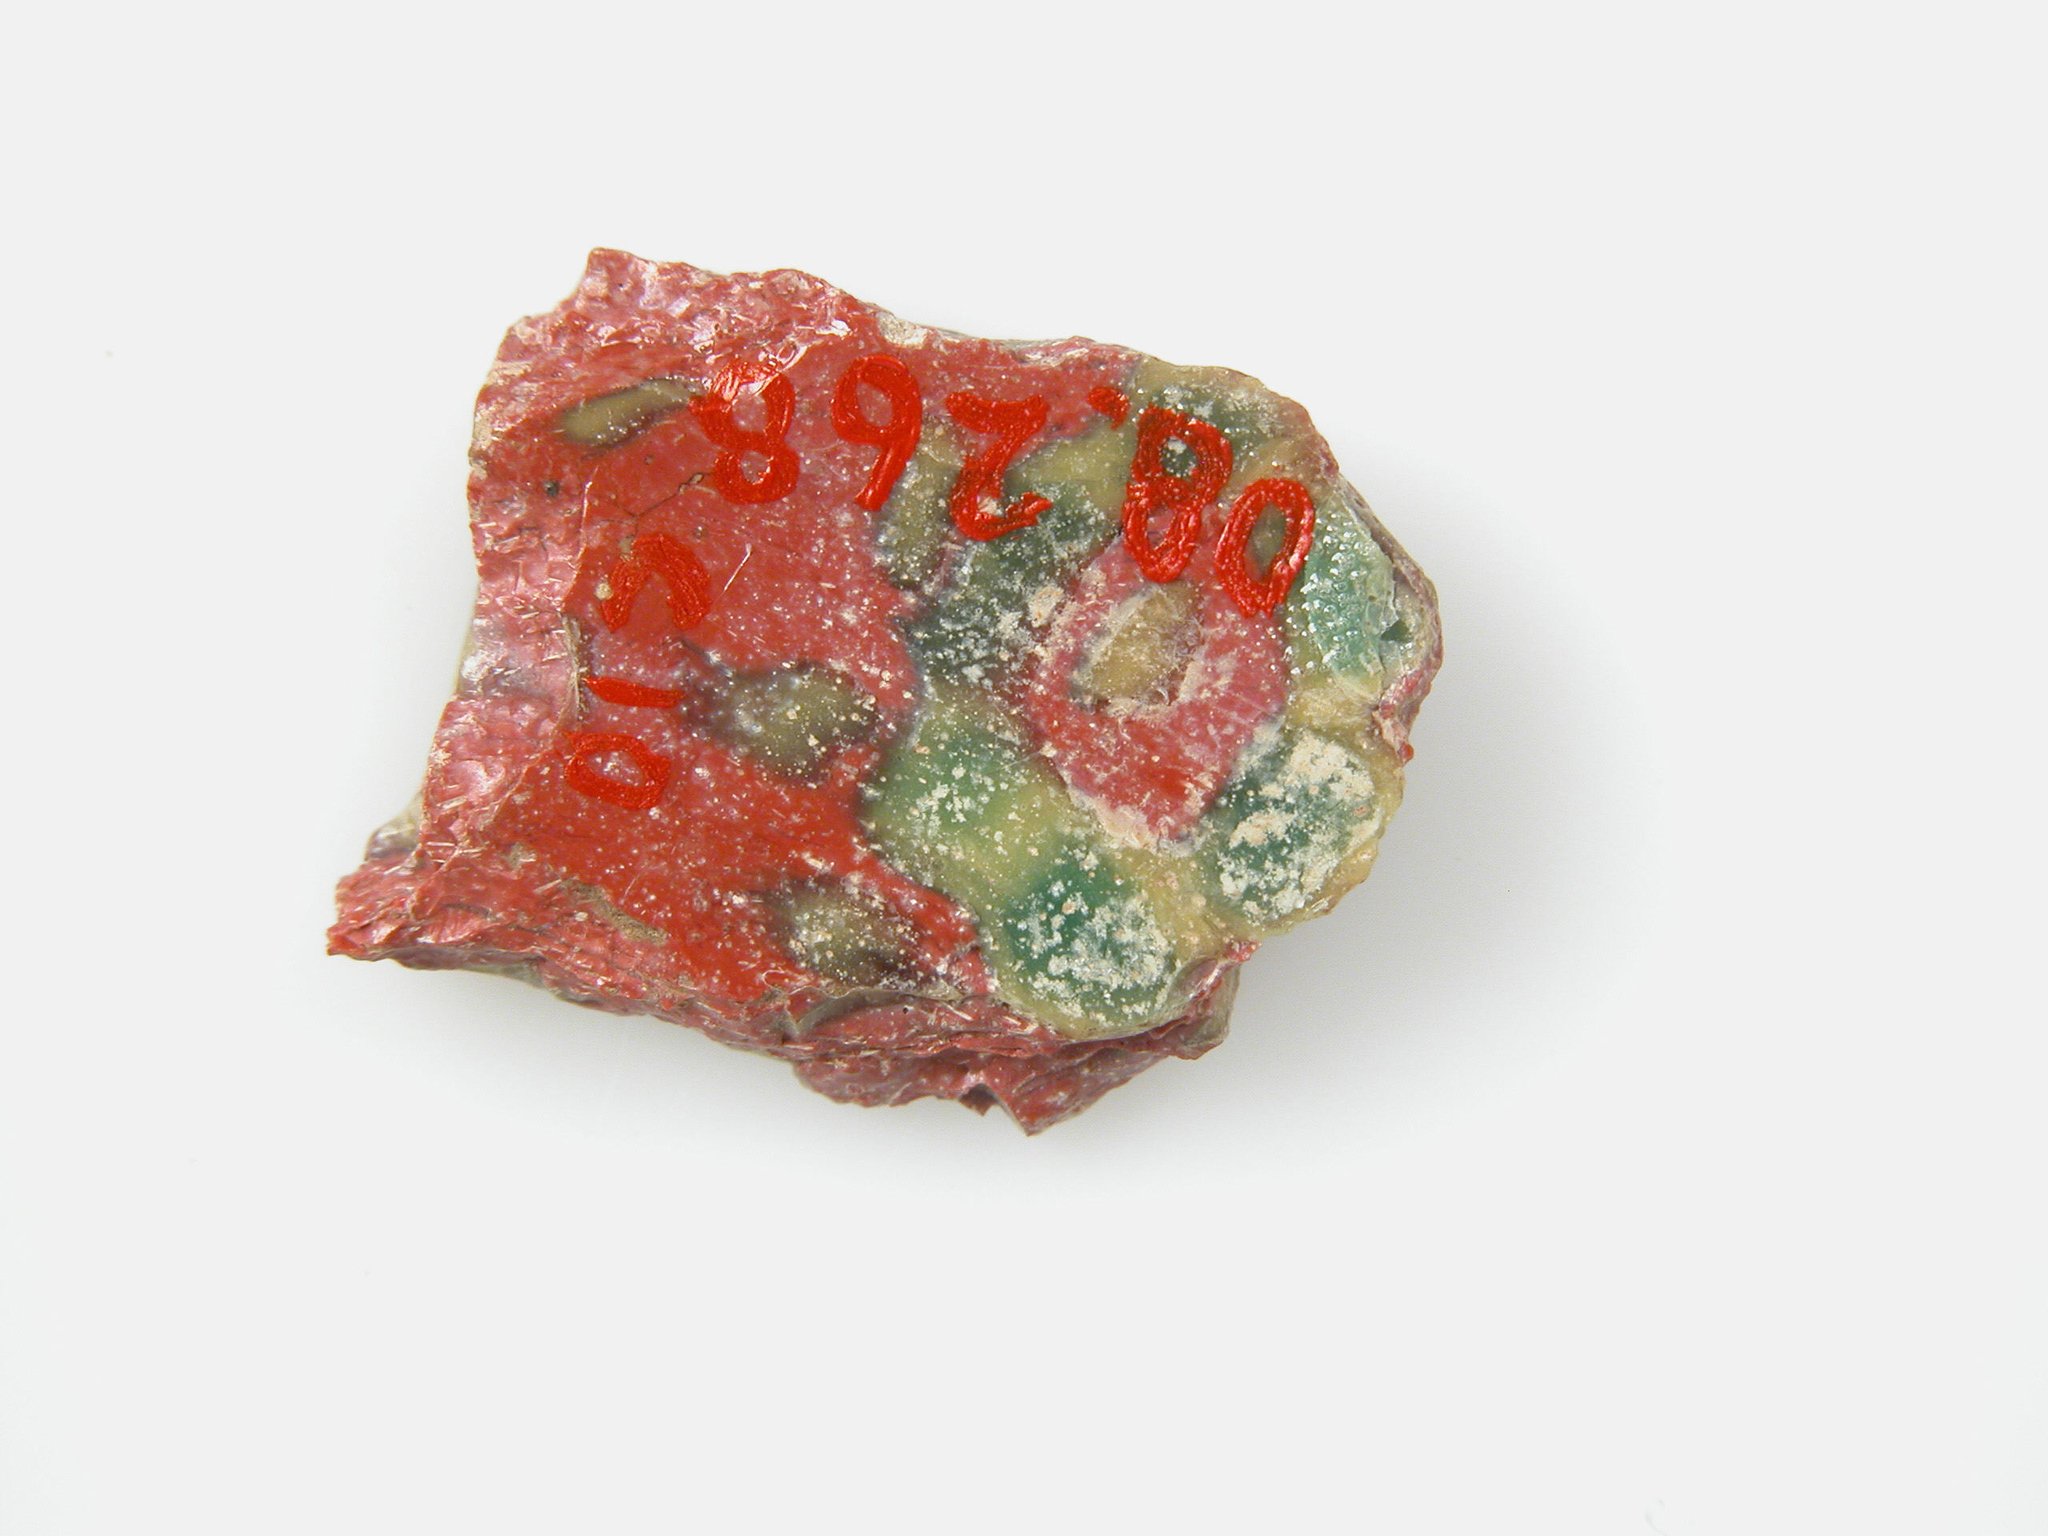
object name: fragment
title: Glass Fragment from a Vessel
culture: coptic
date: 301-433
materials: glass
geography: egypt